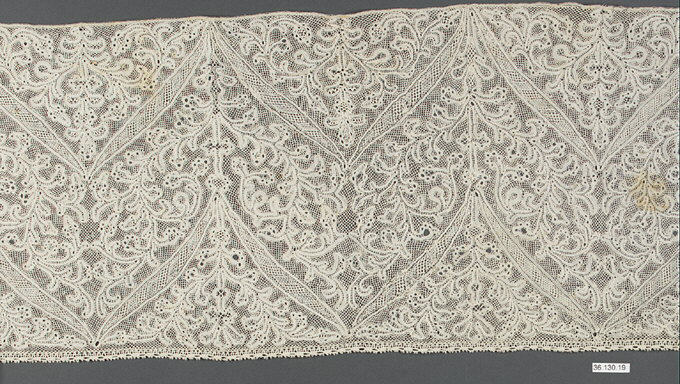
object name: border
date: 1701-1800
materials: lace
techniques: lace